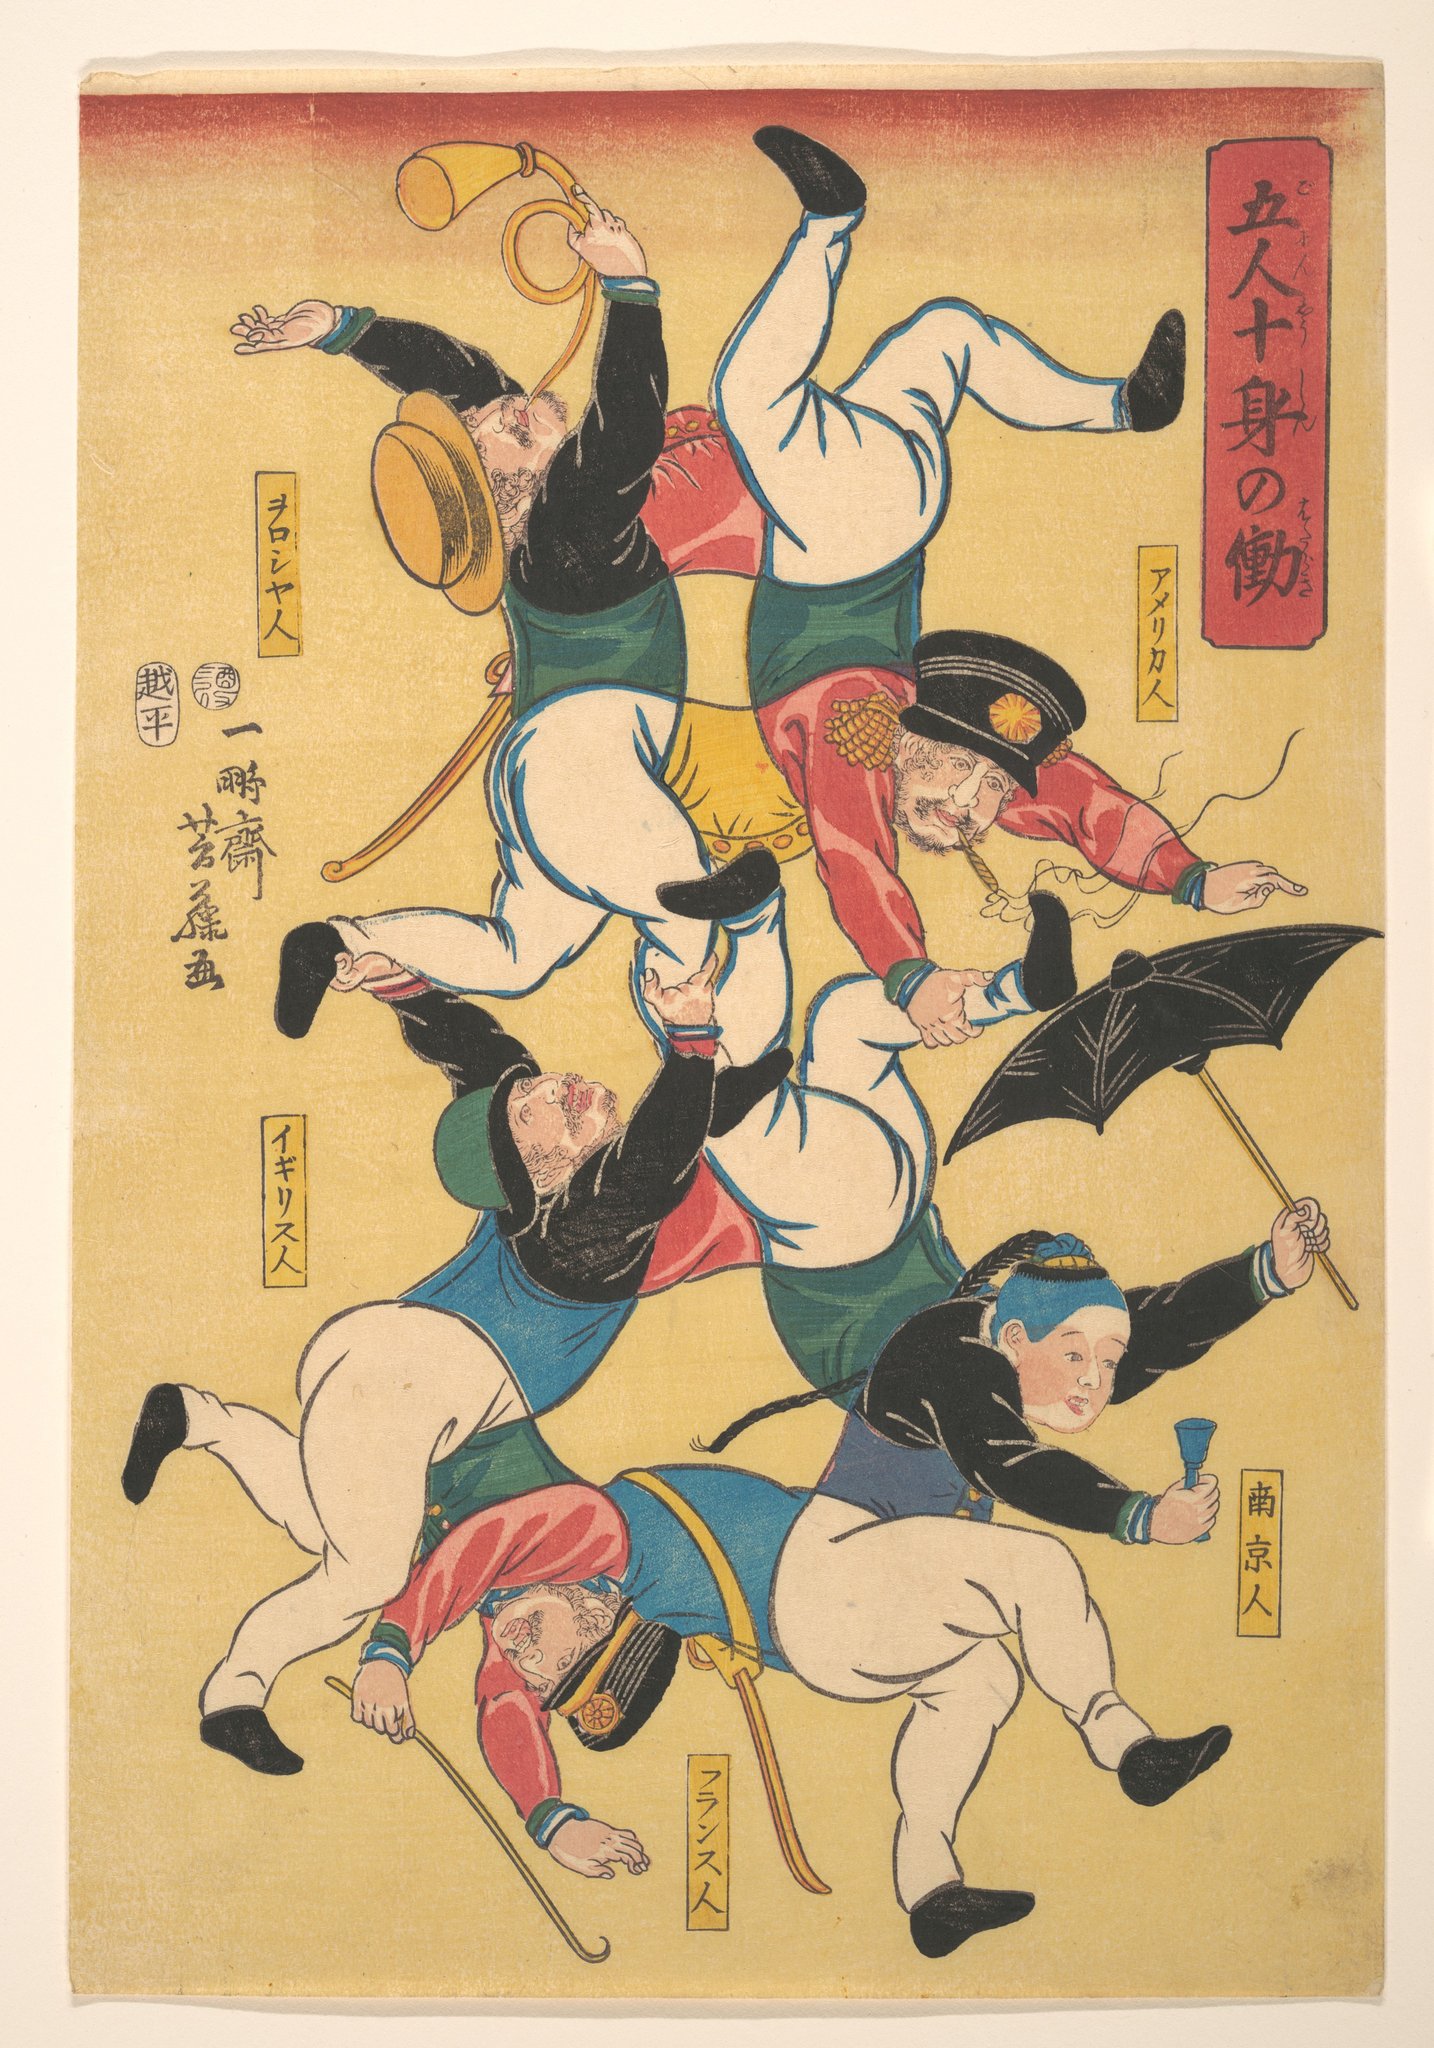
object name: woodblock print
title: Five People Working Like Ten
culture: japanese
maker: ippōsai yoshifuji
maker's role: artist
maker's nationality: japanese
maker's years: 1828-1887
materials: ink, paper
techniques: woodblock print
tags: men,working